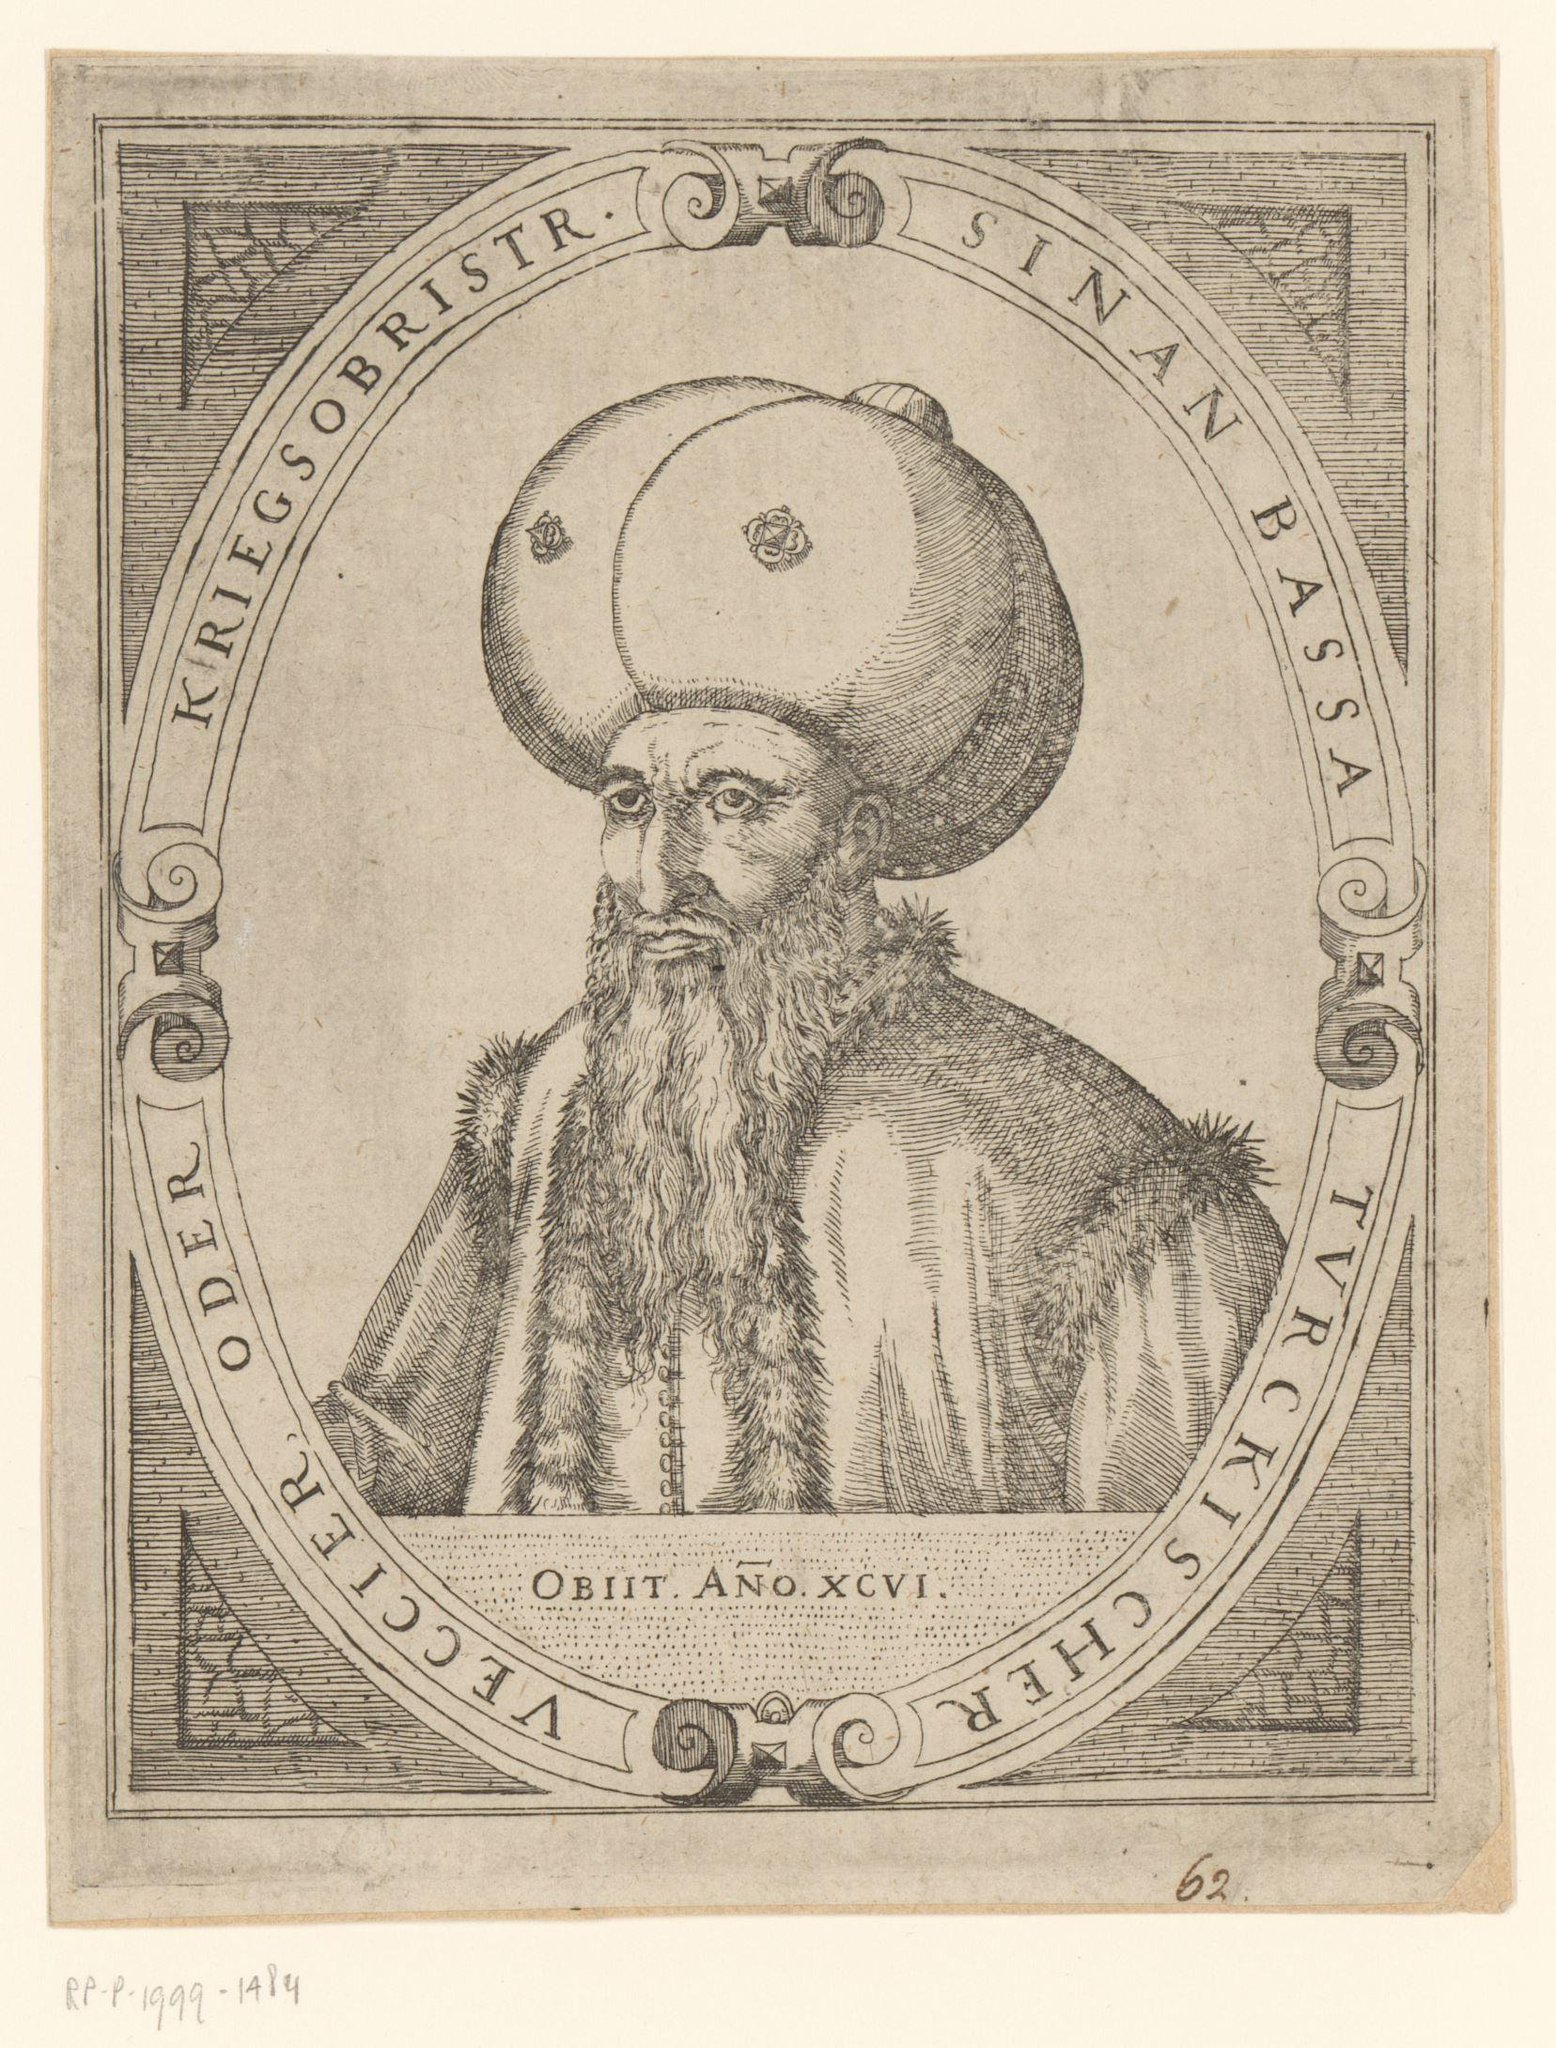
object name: print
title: Portret van Sinan Pasha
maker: hans sibmacher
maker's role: print maker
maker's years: -1611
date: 1590-1611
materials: paper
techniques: etching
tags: historical persons, head-gear: turban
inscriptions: collector's mark: Lugt 2228, collector's mark: Lugt 2760, number: ‘62’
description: Prent ook gebruikt in: Oretlius, Hieronymus. Chronologica (...). Neurenberg: Valentin Fuhrmann et. al., 1602-1665.